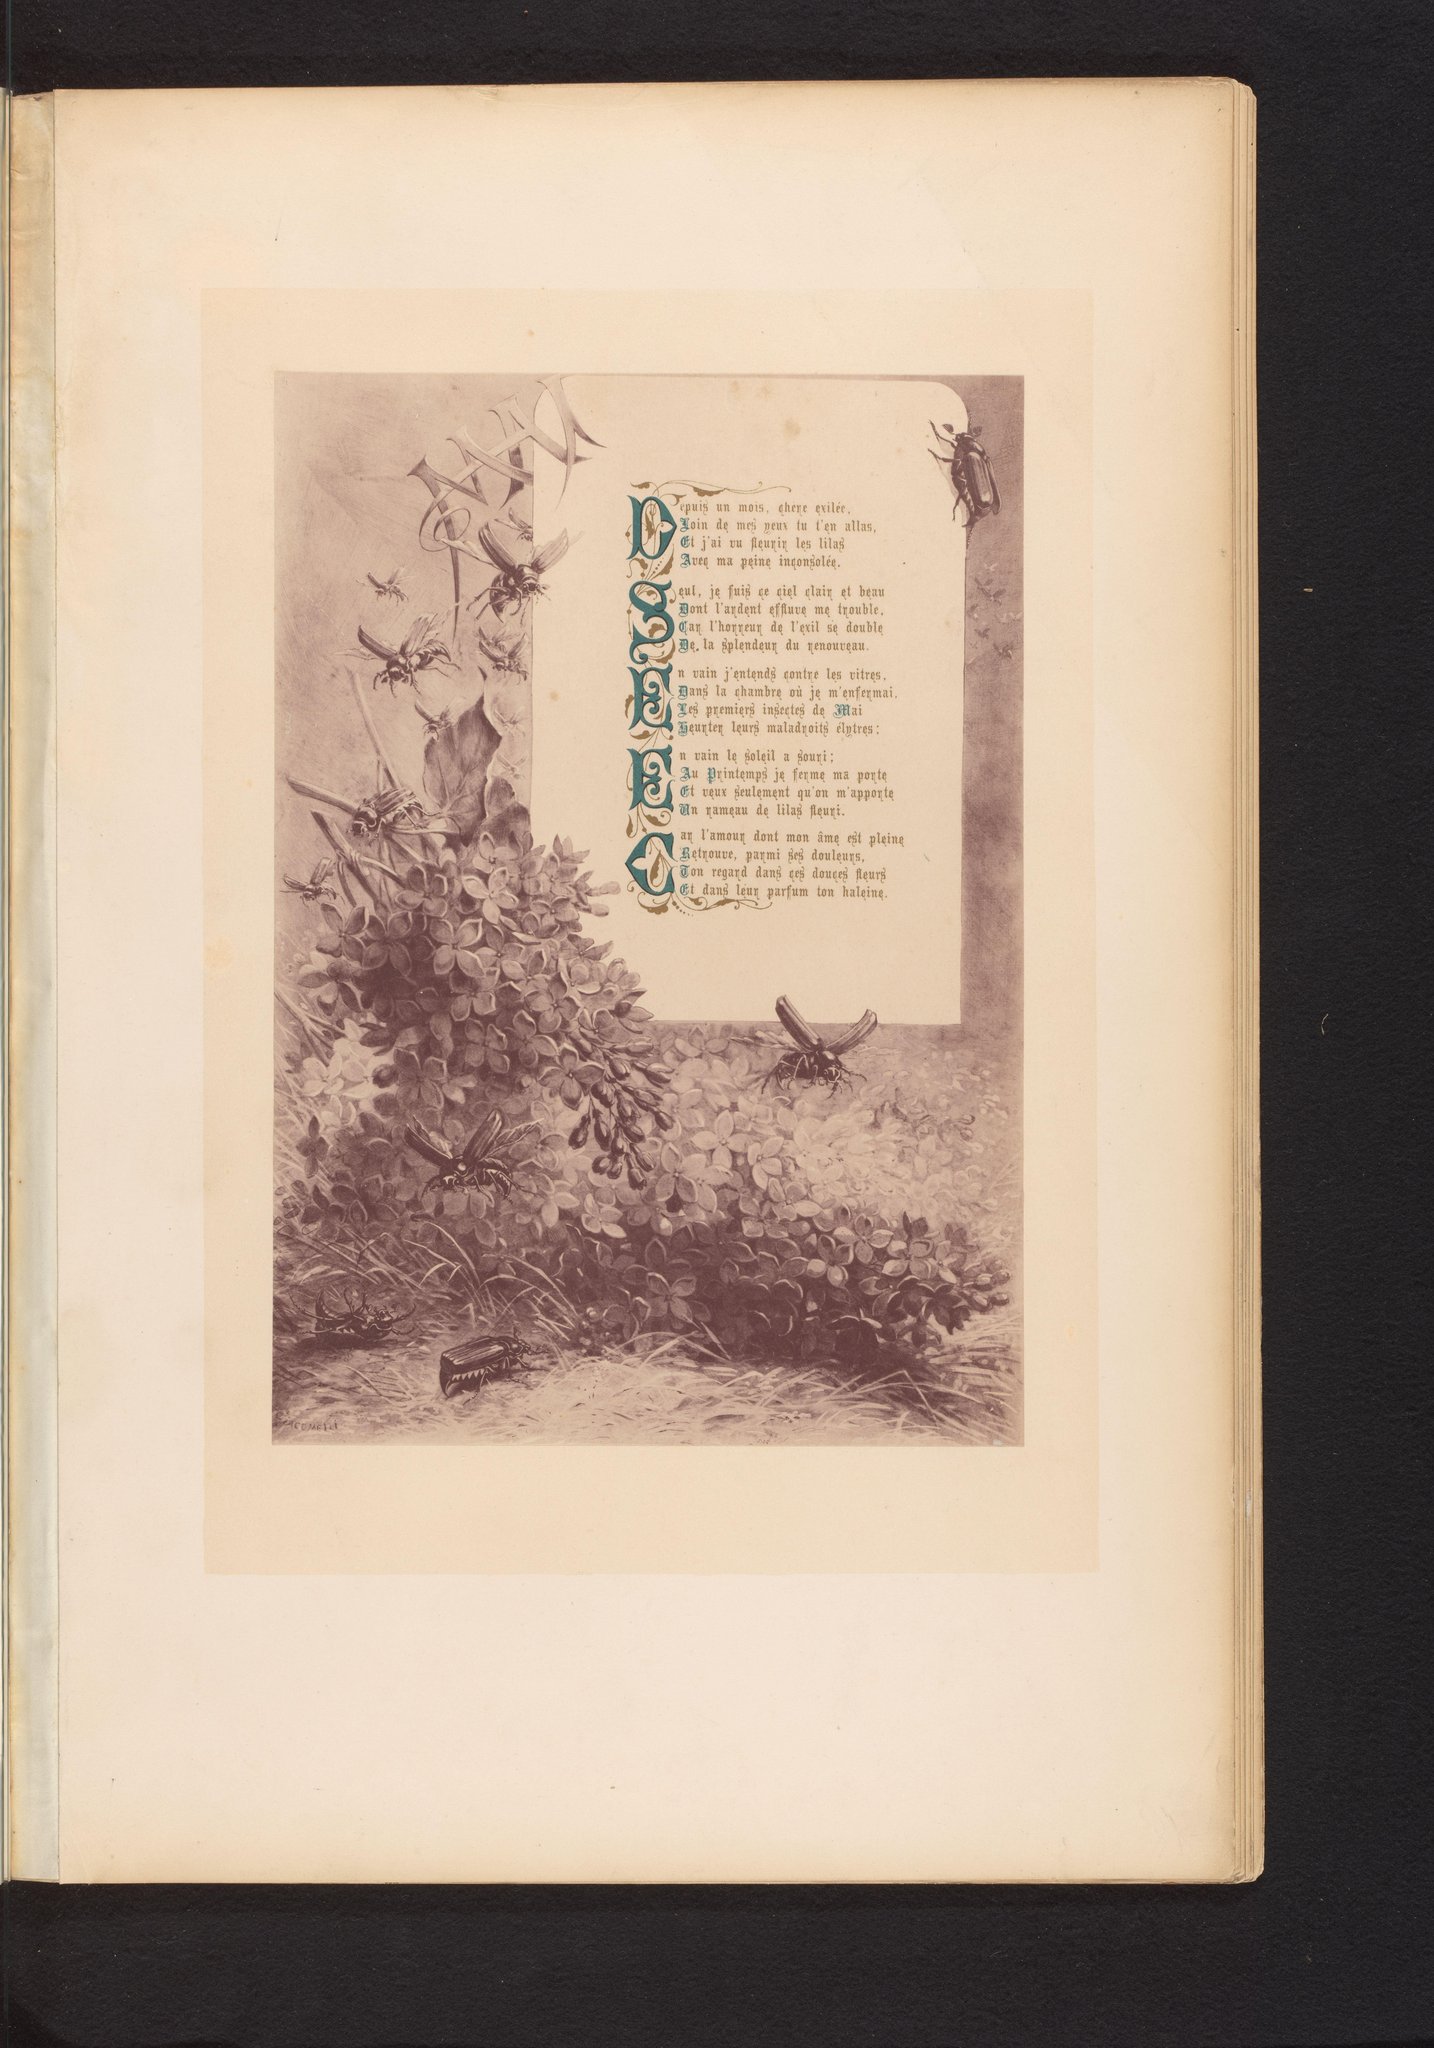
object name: page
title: Reproductie van een prent van insecten en struikgewas, met het gedicht Mai van François Coppée, door Hector Giacomelli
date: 1871-1876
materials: paper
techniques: chromolithography, photograph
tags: shrubs, insects, may ~ other concepts